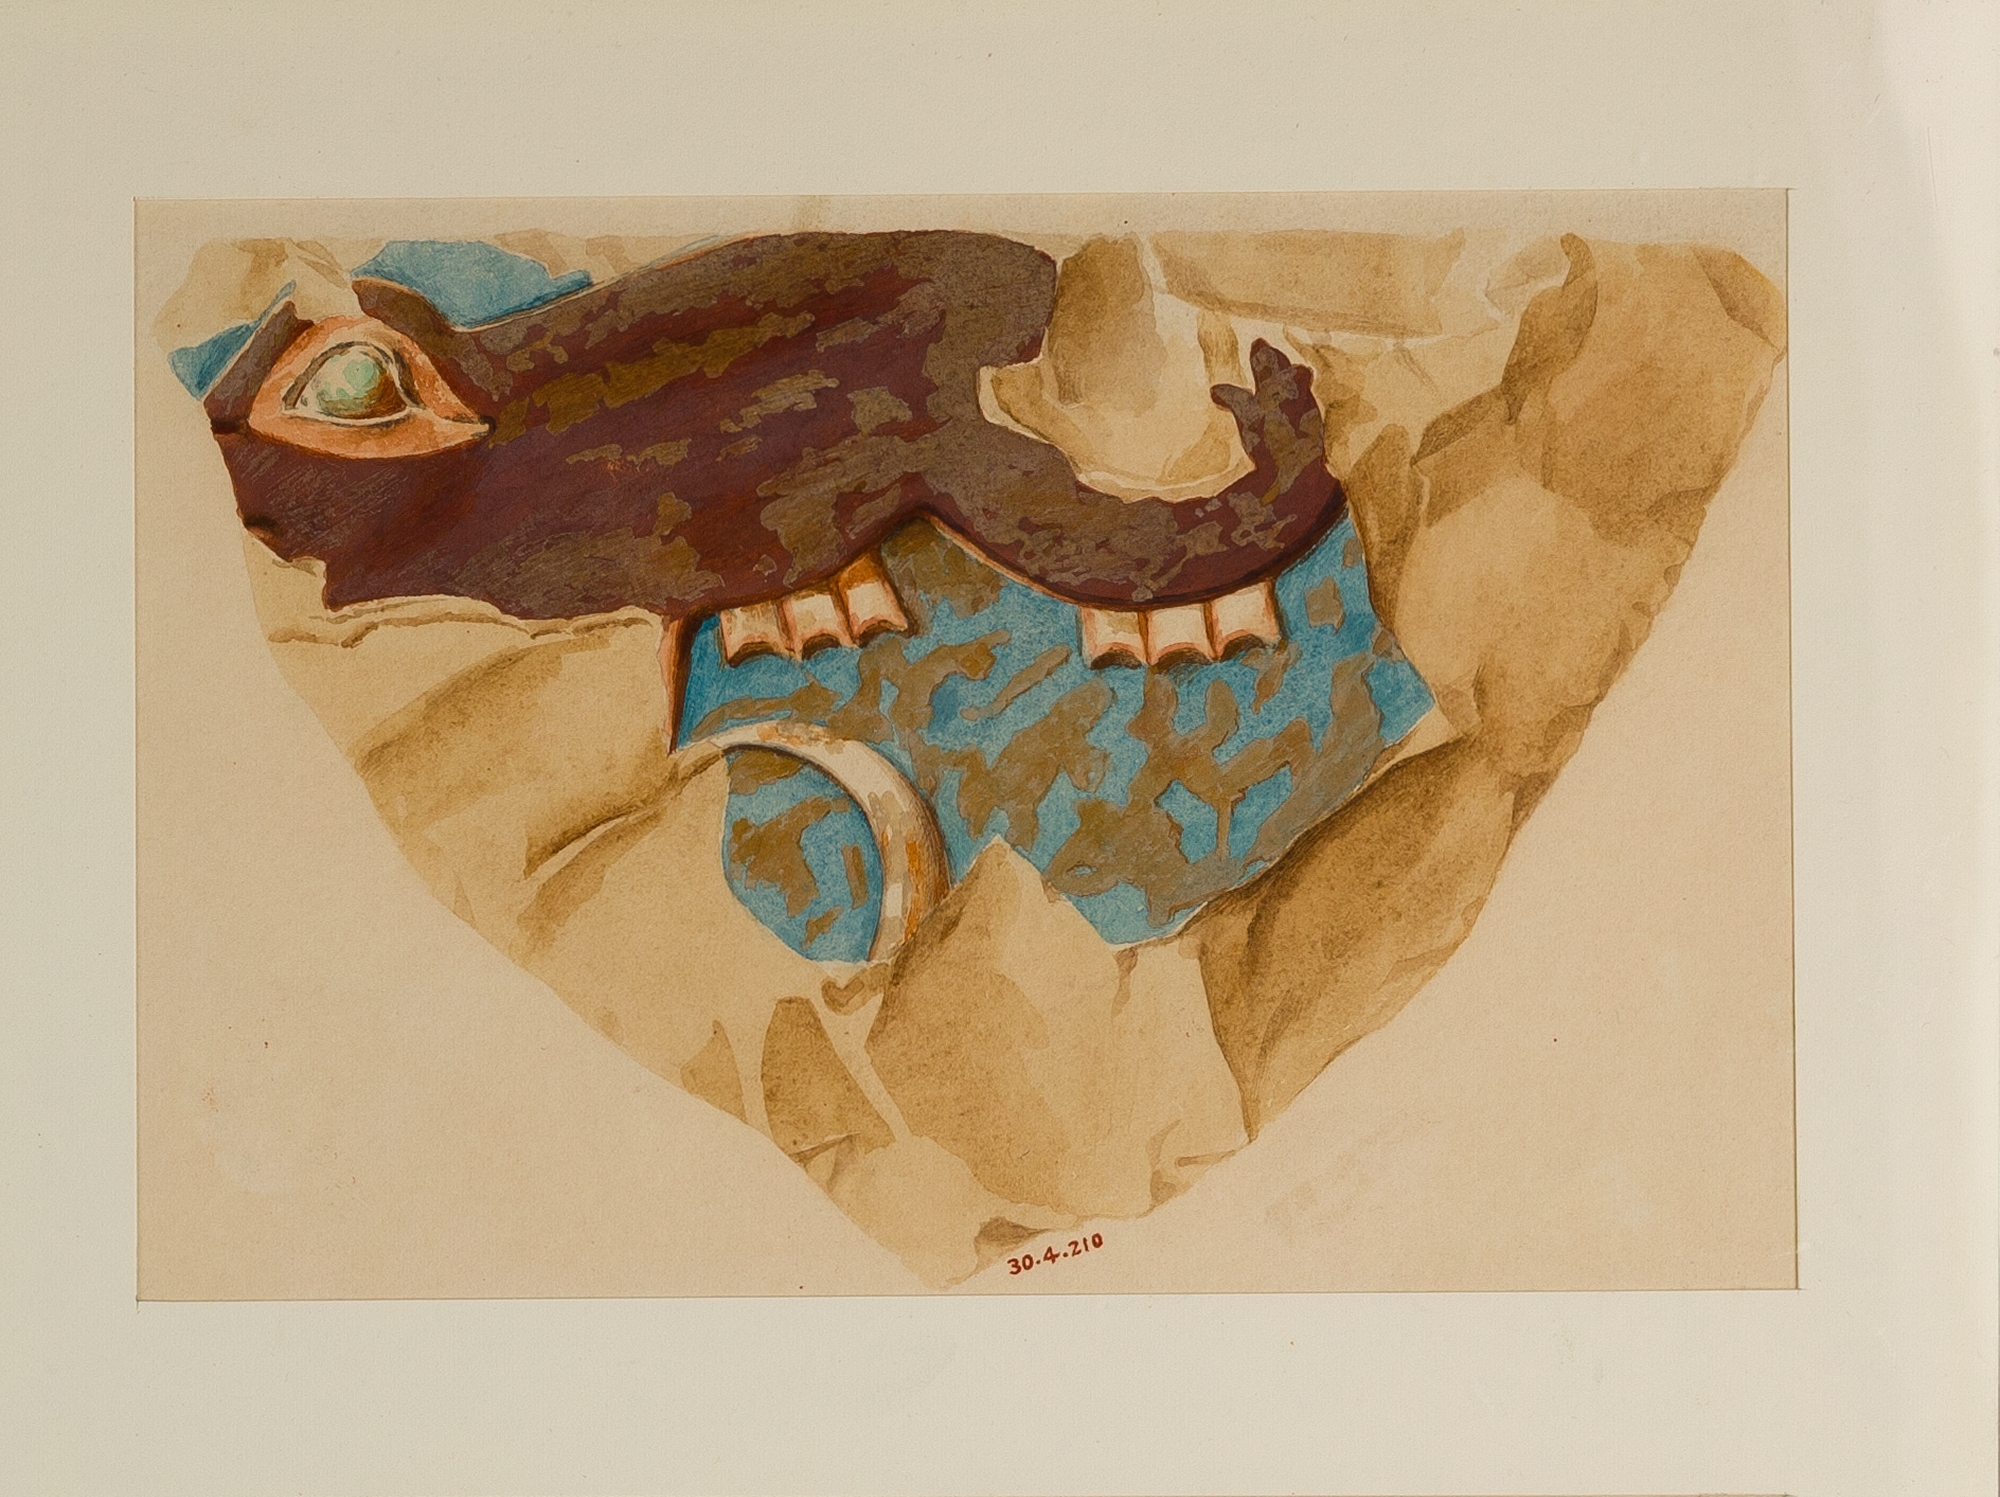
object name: facsimile, puyemre tt 39, hippopotamus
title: Hippopotamus Head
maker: hugh r. hopgood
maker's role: artist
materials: paper, paint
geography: egypt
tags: hippos